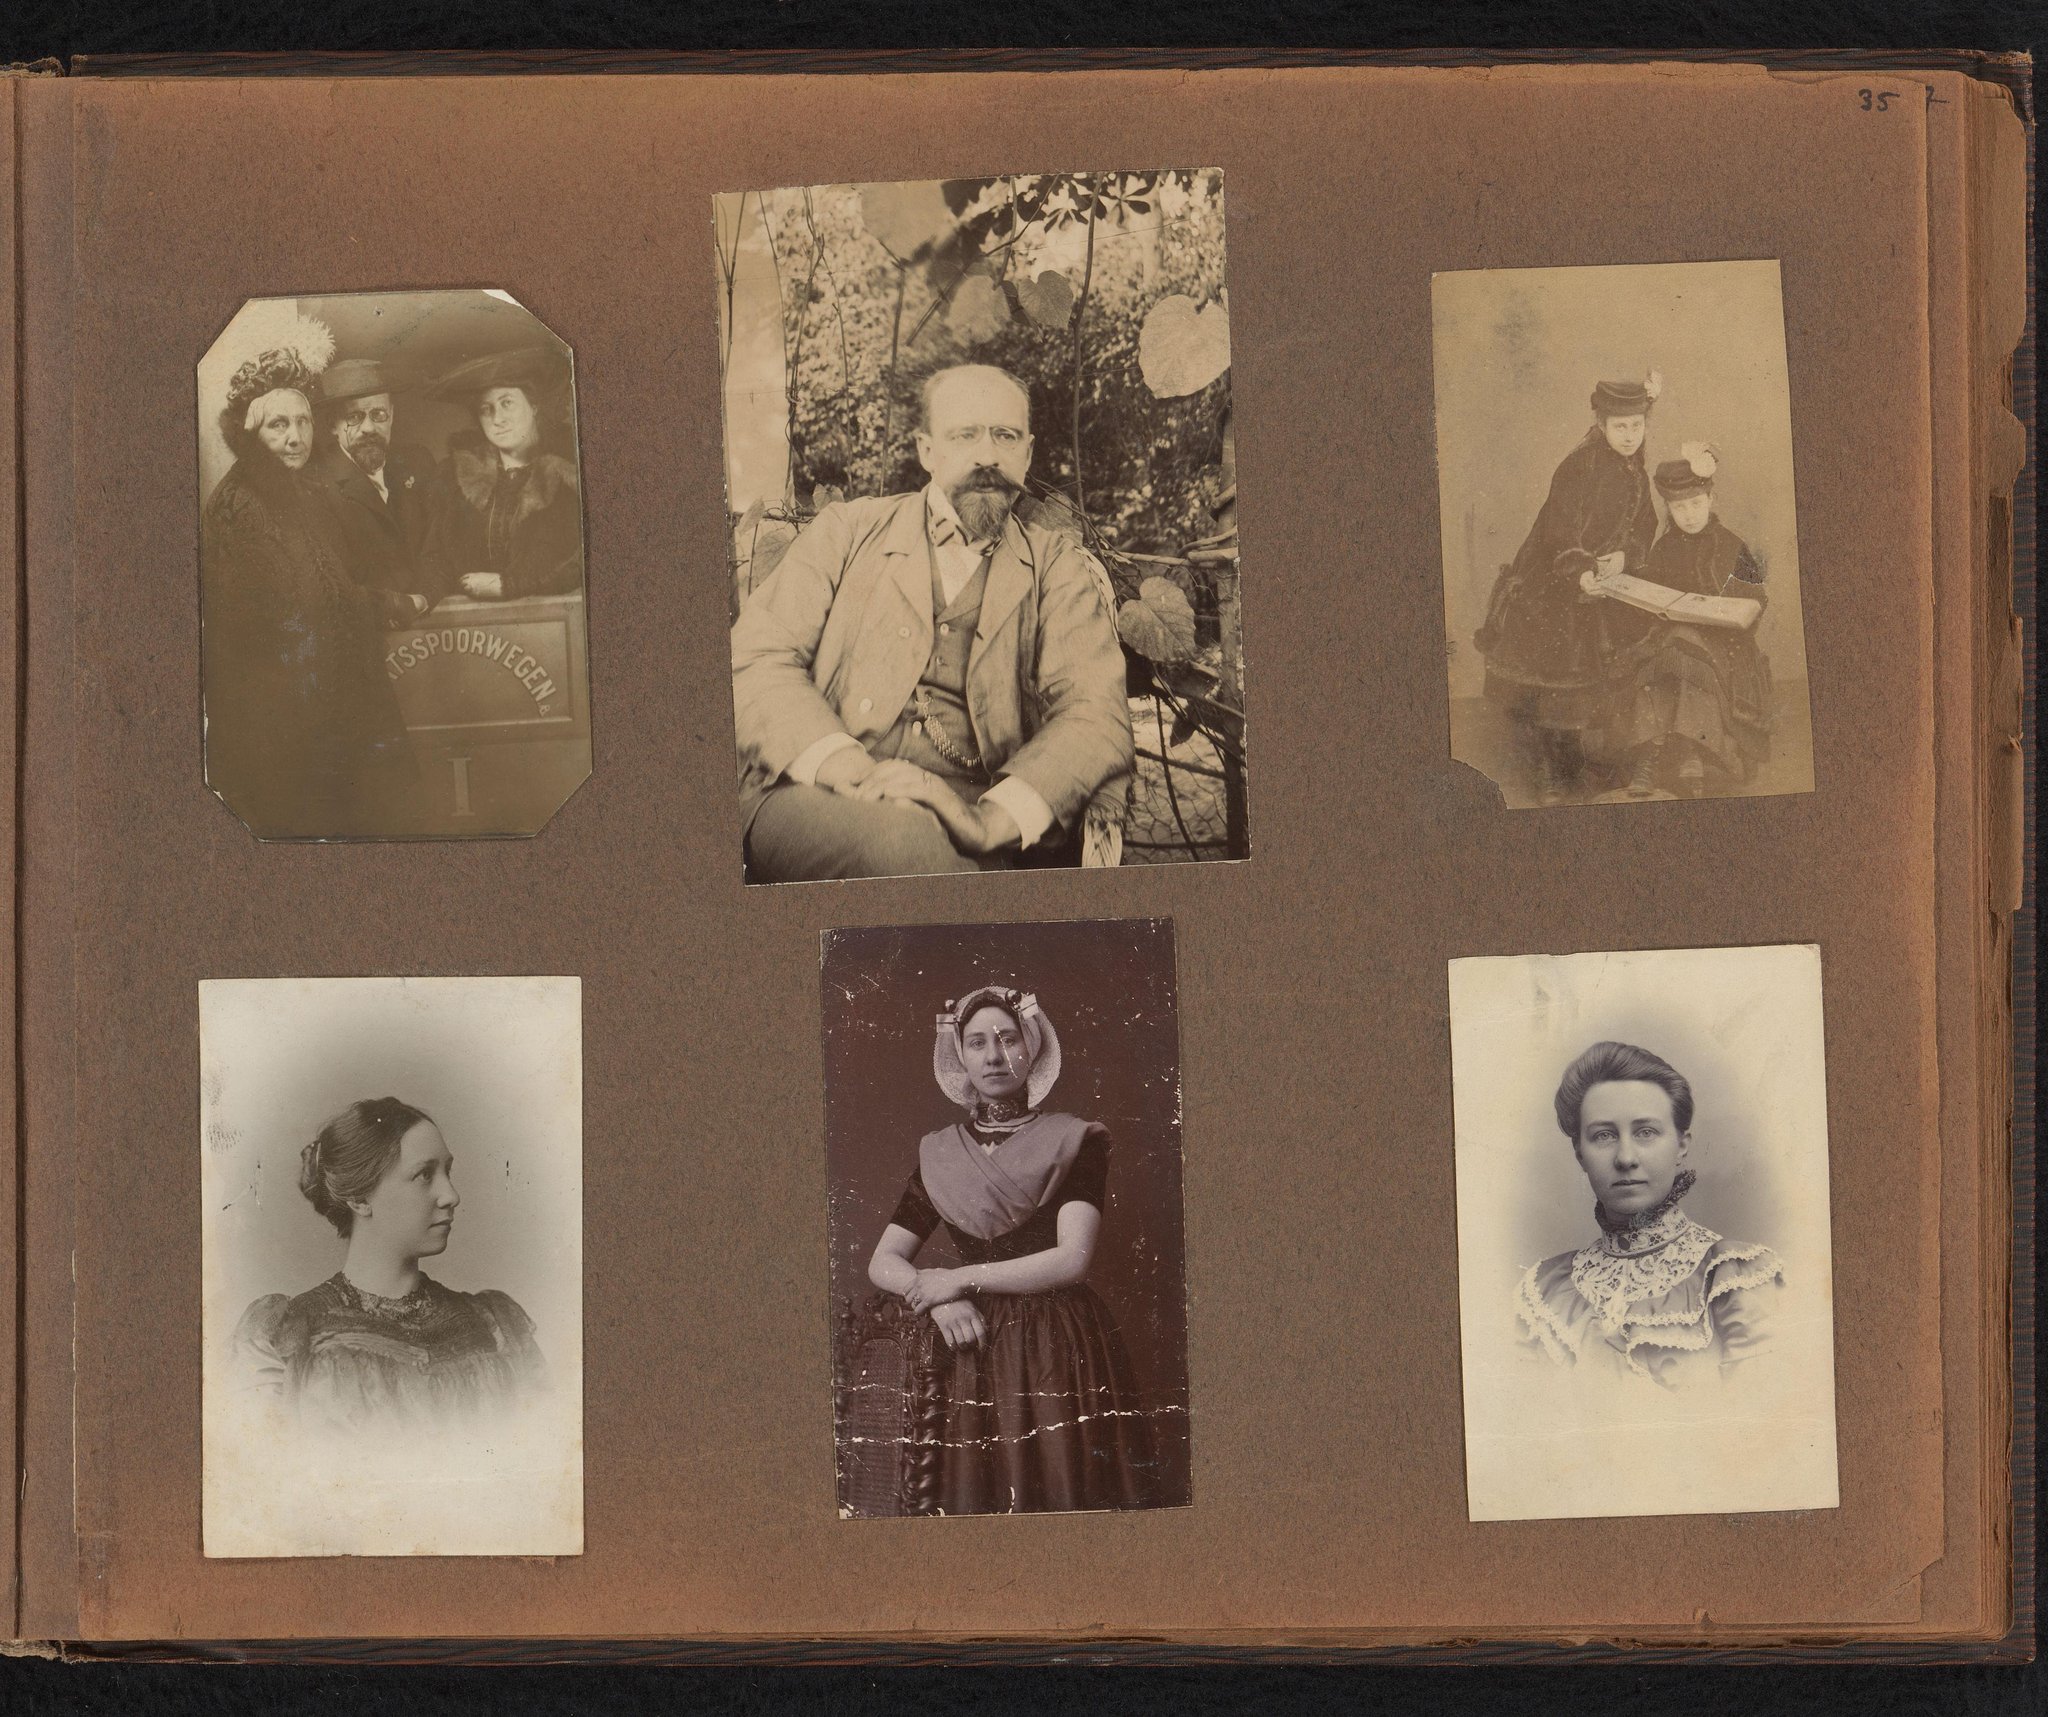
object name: photograph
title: Bladzijde uit het fotoalbum van de familie Diepenbrock met 6 foto's van Alphons Diepenbrock en zijn omgeving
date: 1895-1925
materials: cardboard, photographic support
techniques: photography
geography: amsterdam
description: Bruin albumblad 35 van familiealbum van Alphons Diepenbrock. Bladzijde uit het fotoalbum van de familie Diepenbrock met portretten van Elsa.